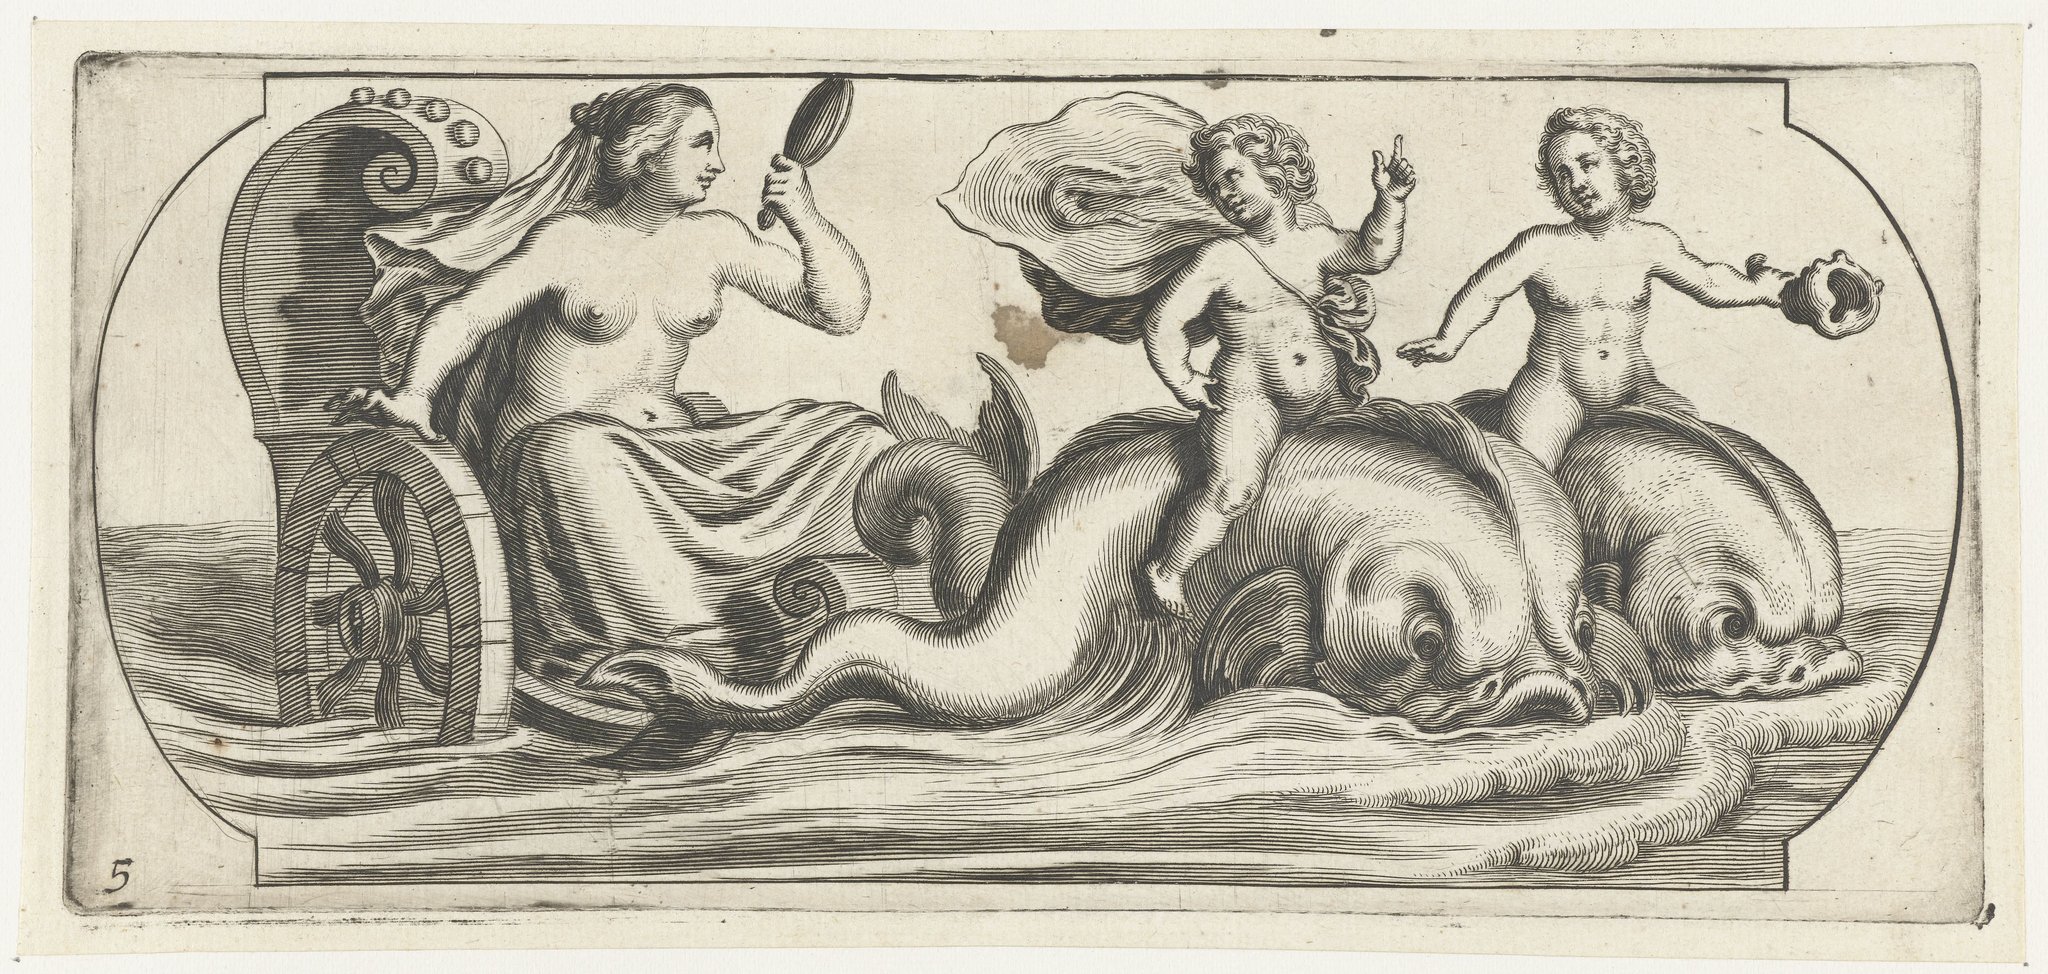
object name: print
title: Nouveau Livre des Dieux et Deeßes De la Marine Bouckje van Zeegoden en Godinnen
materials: paper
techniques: engraving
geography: amsterdam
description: Amphitrite zit op een strijdwagen die voortgetrokken wordt door twee dolfijnen met putti. Zij kijkt in een handspiegel.